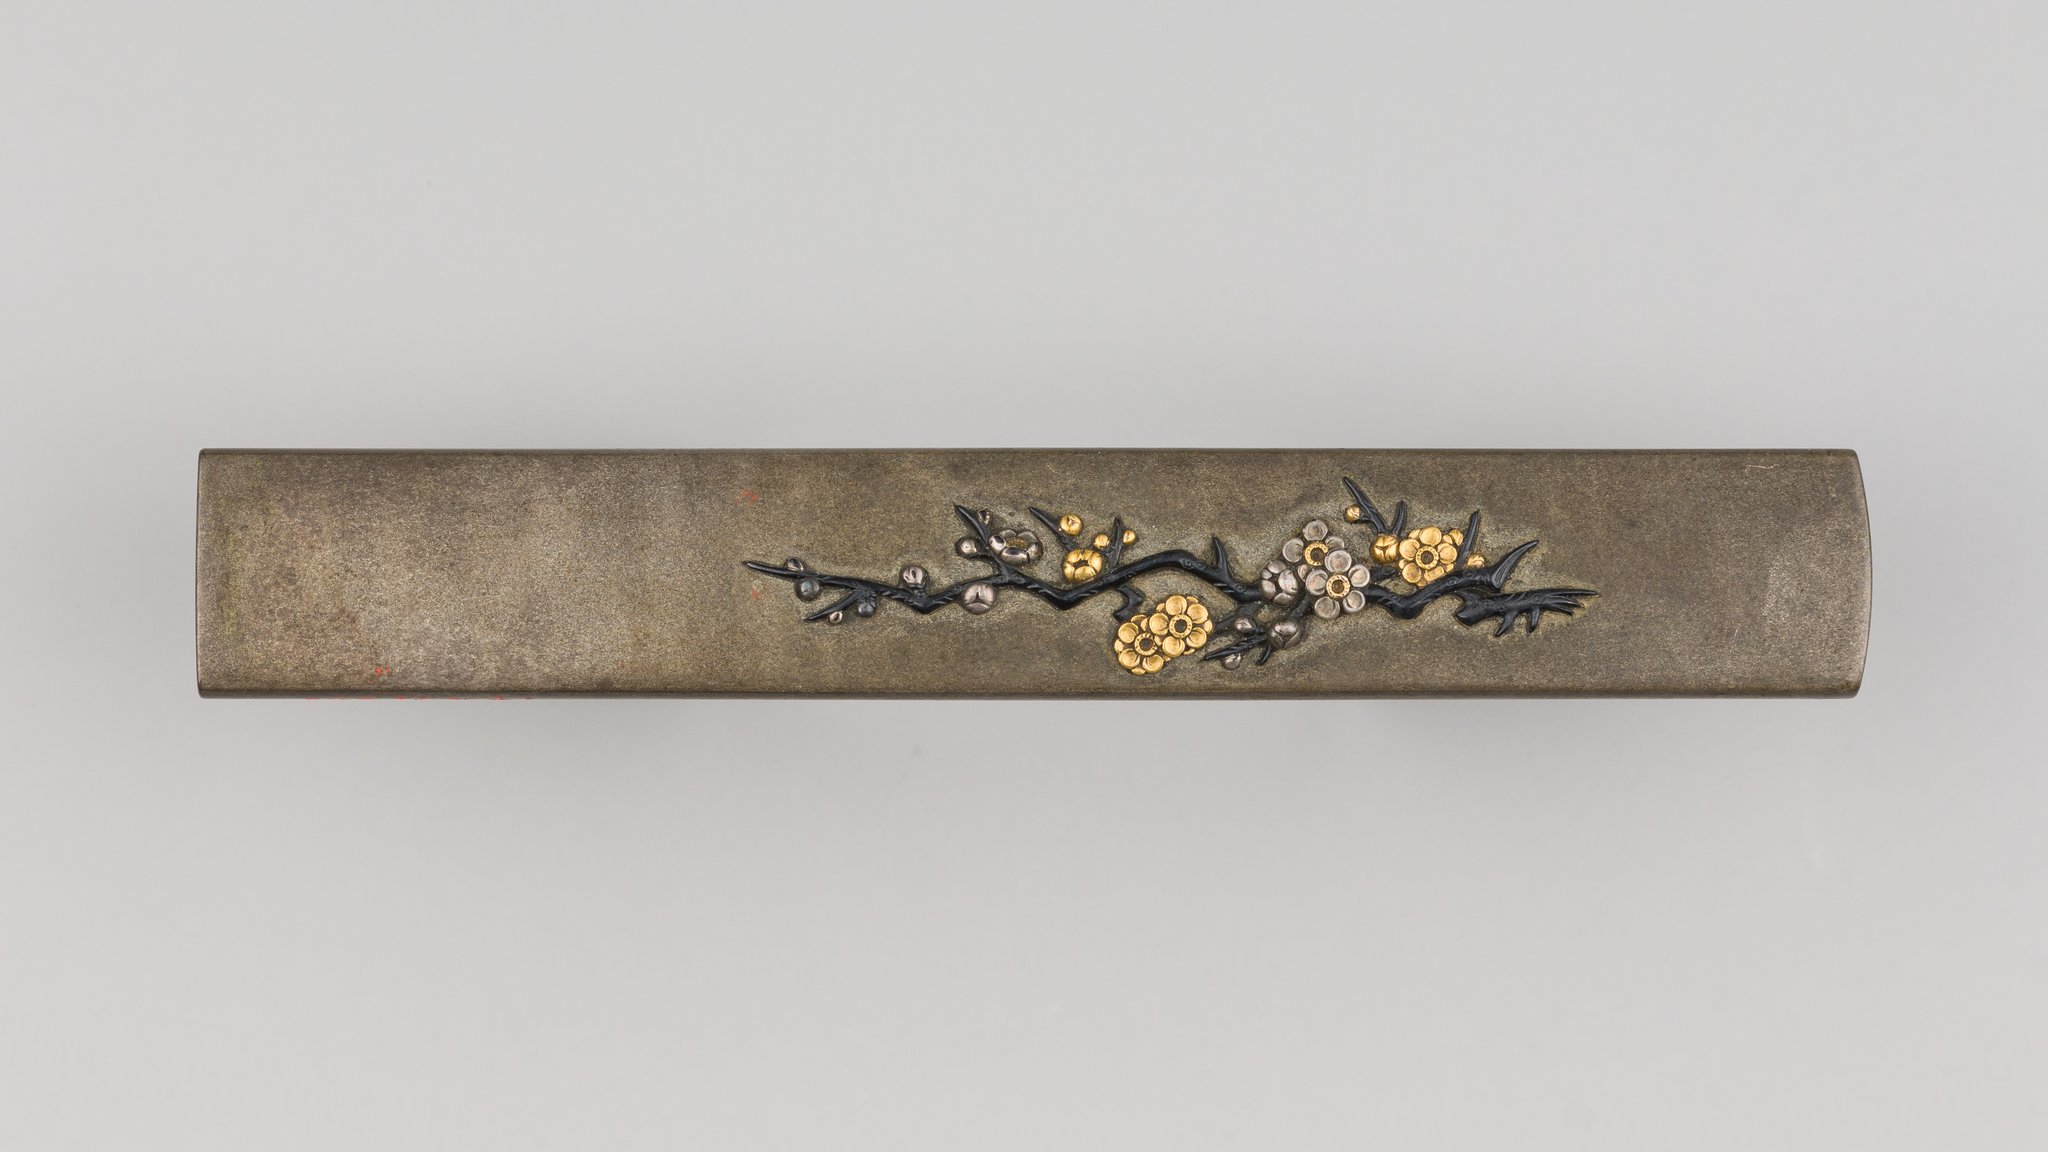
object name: knife handle kozuka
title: Knife Handle (Kozuka)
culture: japanese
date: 1701-1800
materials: gold alloy, silver alloy, gold, silver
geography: japan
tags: flowers